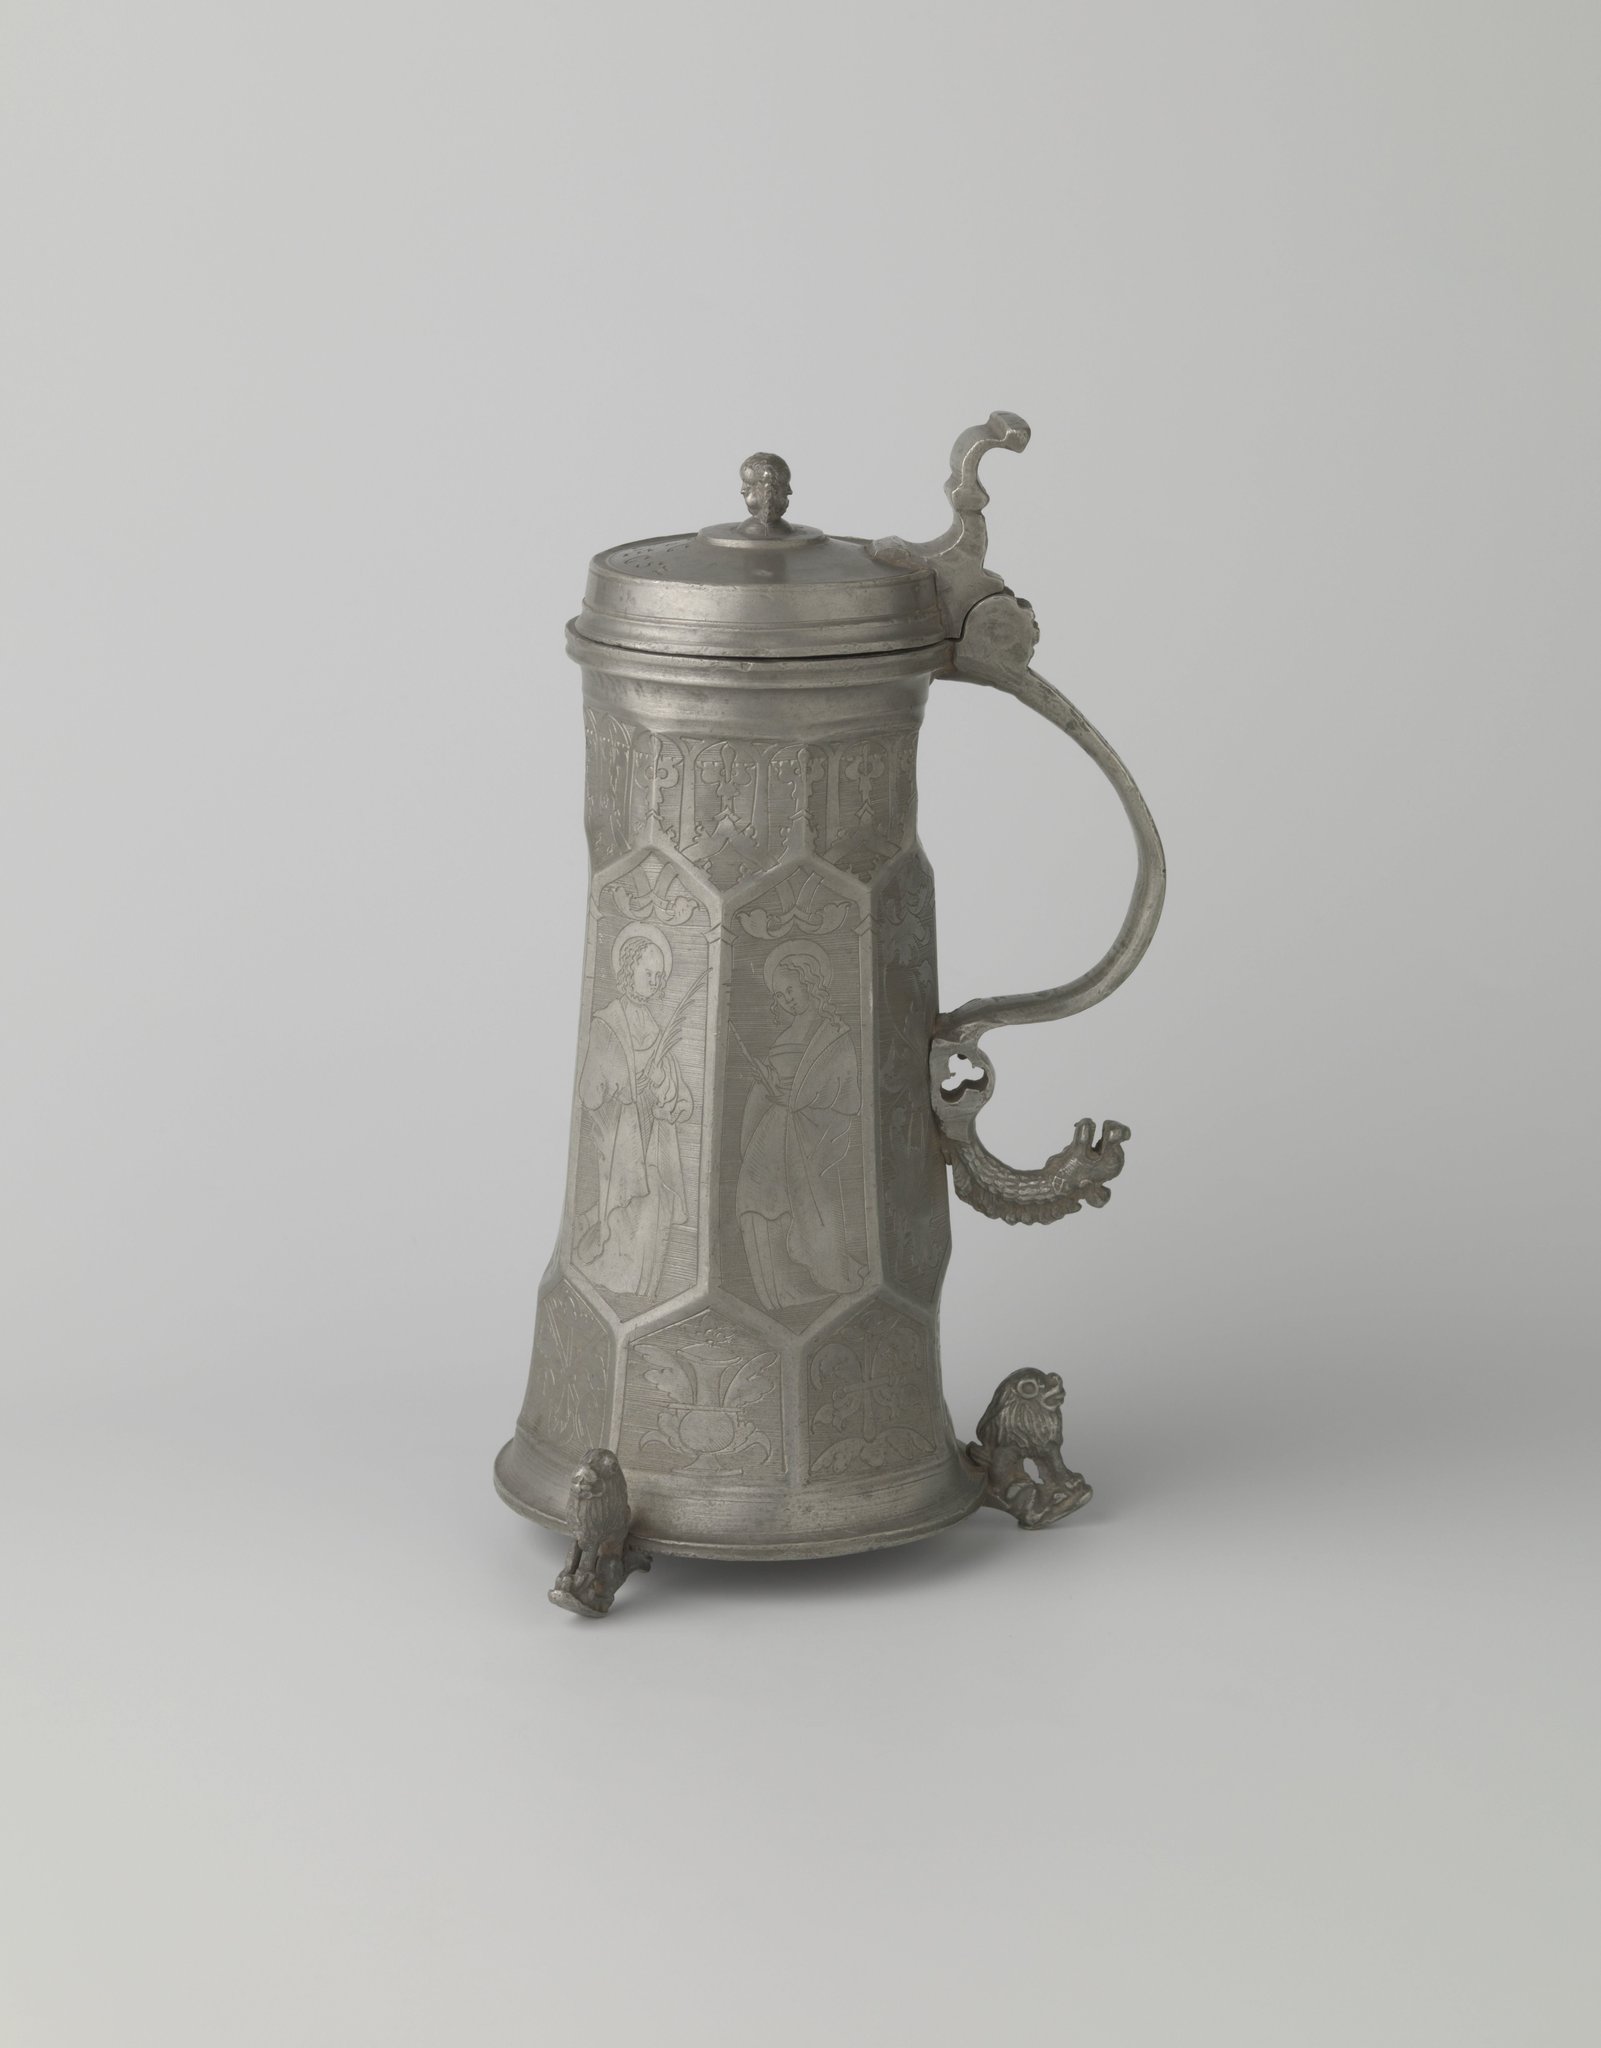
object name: jug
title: Zevenkantige kruik van tin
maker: Anonymous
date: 1800-1850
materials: tin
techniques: casting, turning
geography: germany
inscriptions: inscription (): ‘P.K.’, quality mark (false), inscription (false): ‘GG // 16EGSZ’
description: Zevenkantige kruik van tin. De drie pootjes worden gevormd door leeuwen, waarop de kruik rust. Op de kruik zijn in vakken rank- en bloemmotieven afgebeeld en een vijftal vrouwelijke heiligen. Het licht gewelfde deksel loopt vrij recht omhoog en is geprofileerd. De knop wordt gevormd door een engelkopje met vleugels. Het eenvoudige duimrust gaat via een dubbelkakig, getand scharnier over in het handvat. Het handvat krult onderaan omhoog en eindigt in een beestenkop. Aan de binnenzijde zijn het deksel en de bodem versierd met een rozet omringd door een parelrand.